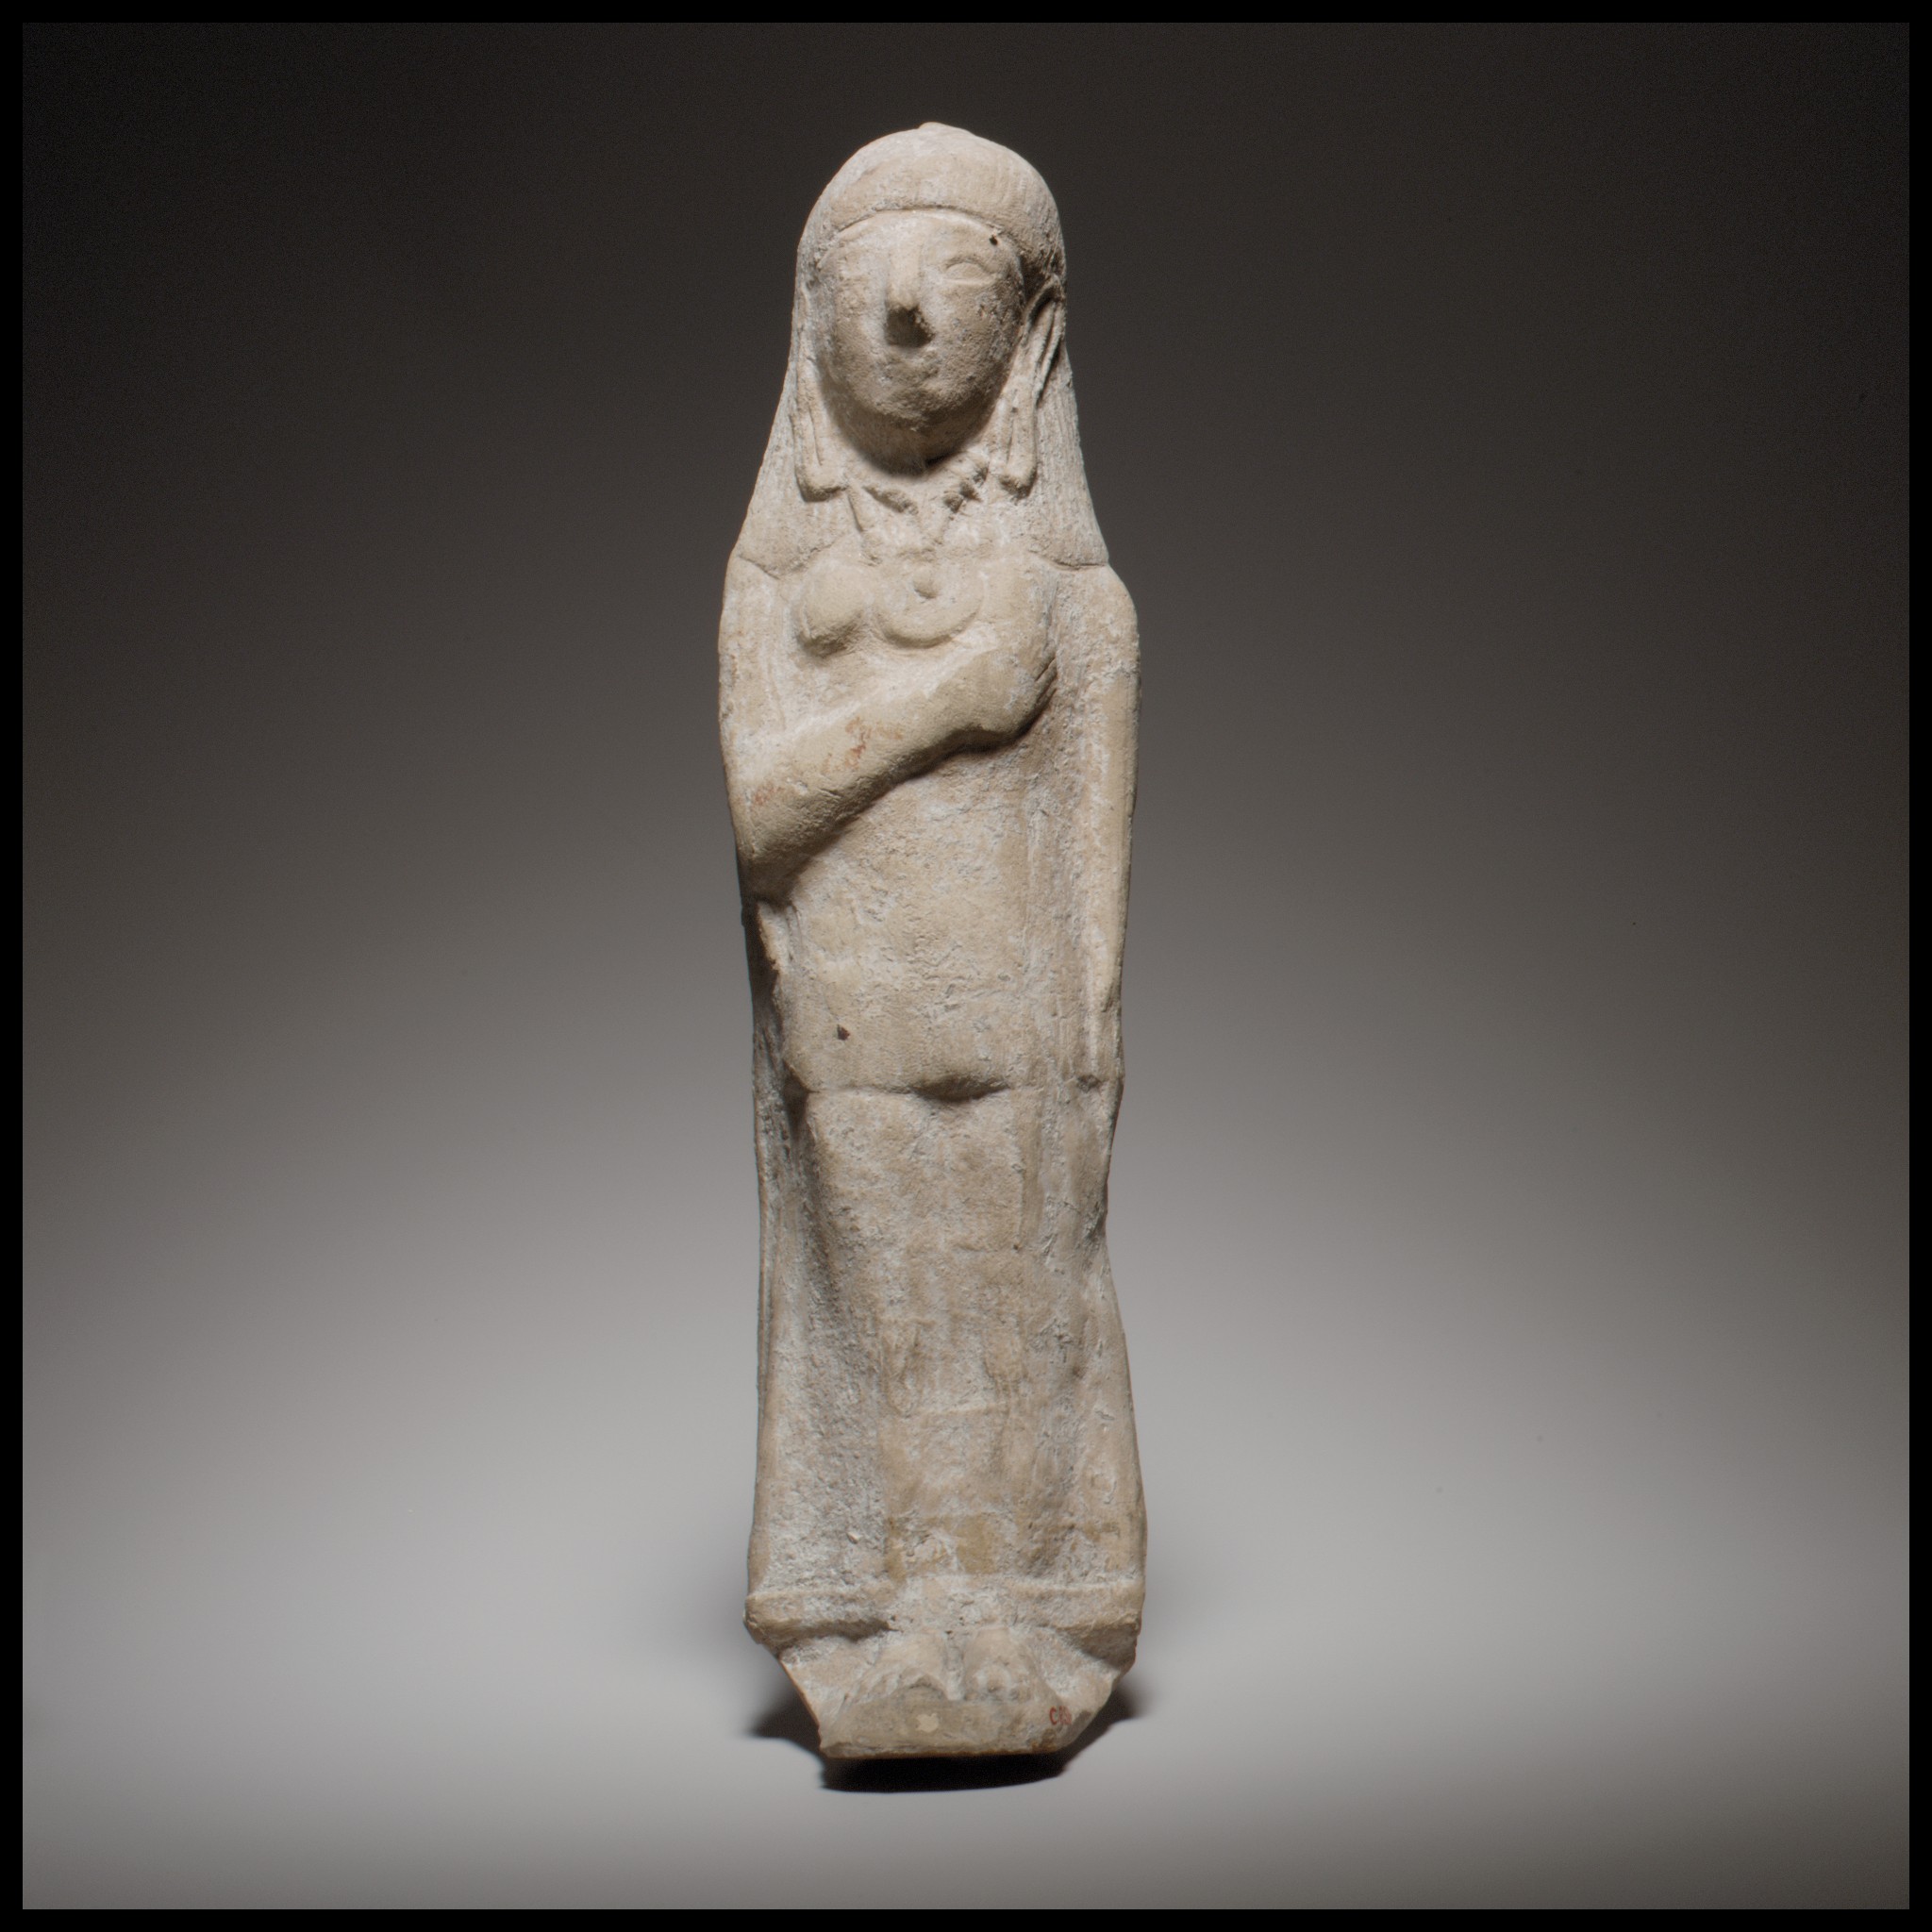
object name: statuette of a woman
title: Terracotta statuette of a woman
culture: cypriot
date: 600-480 BCE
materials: terracotta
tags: women